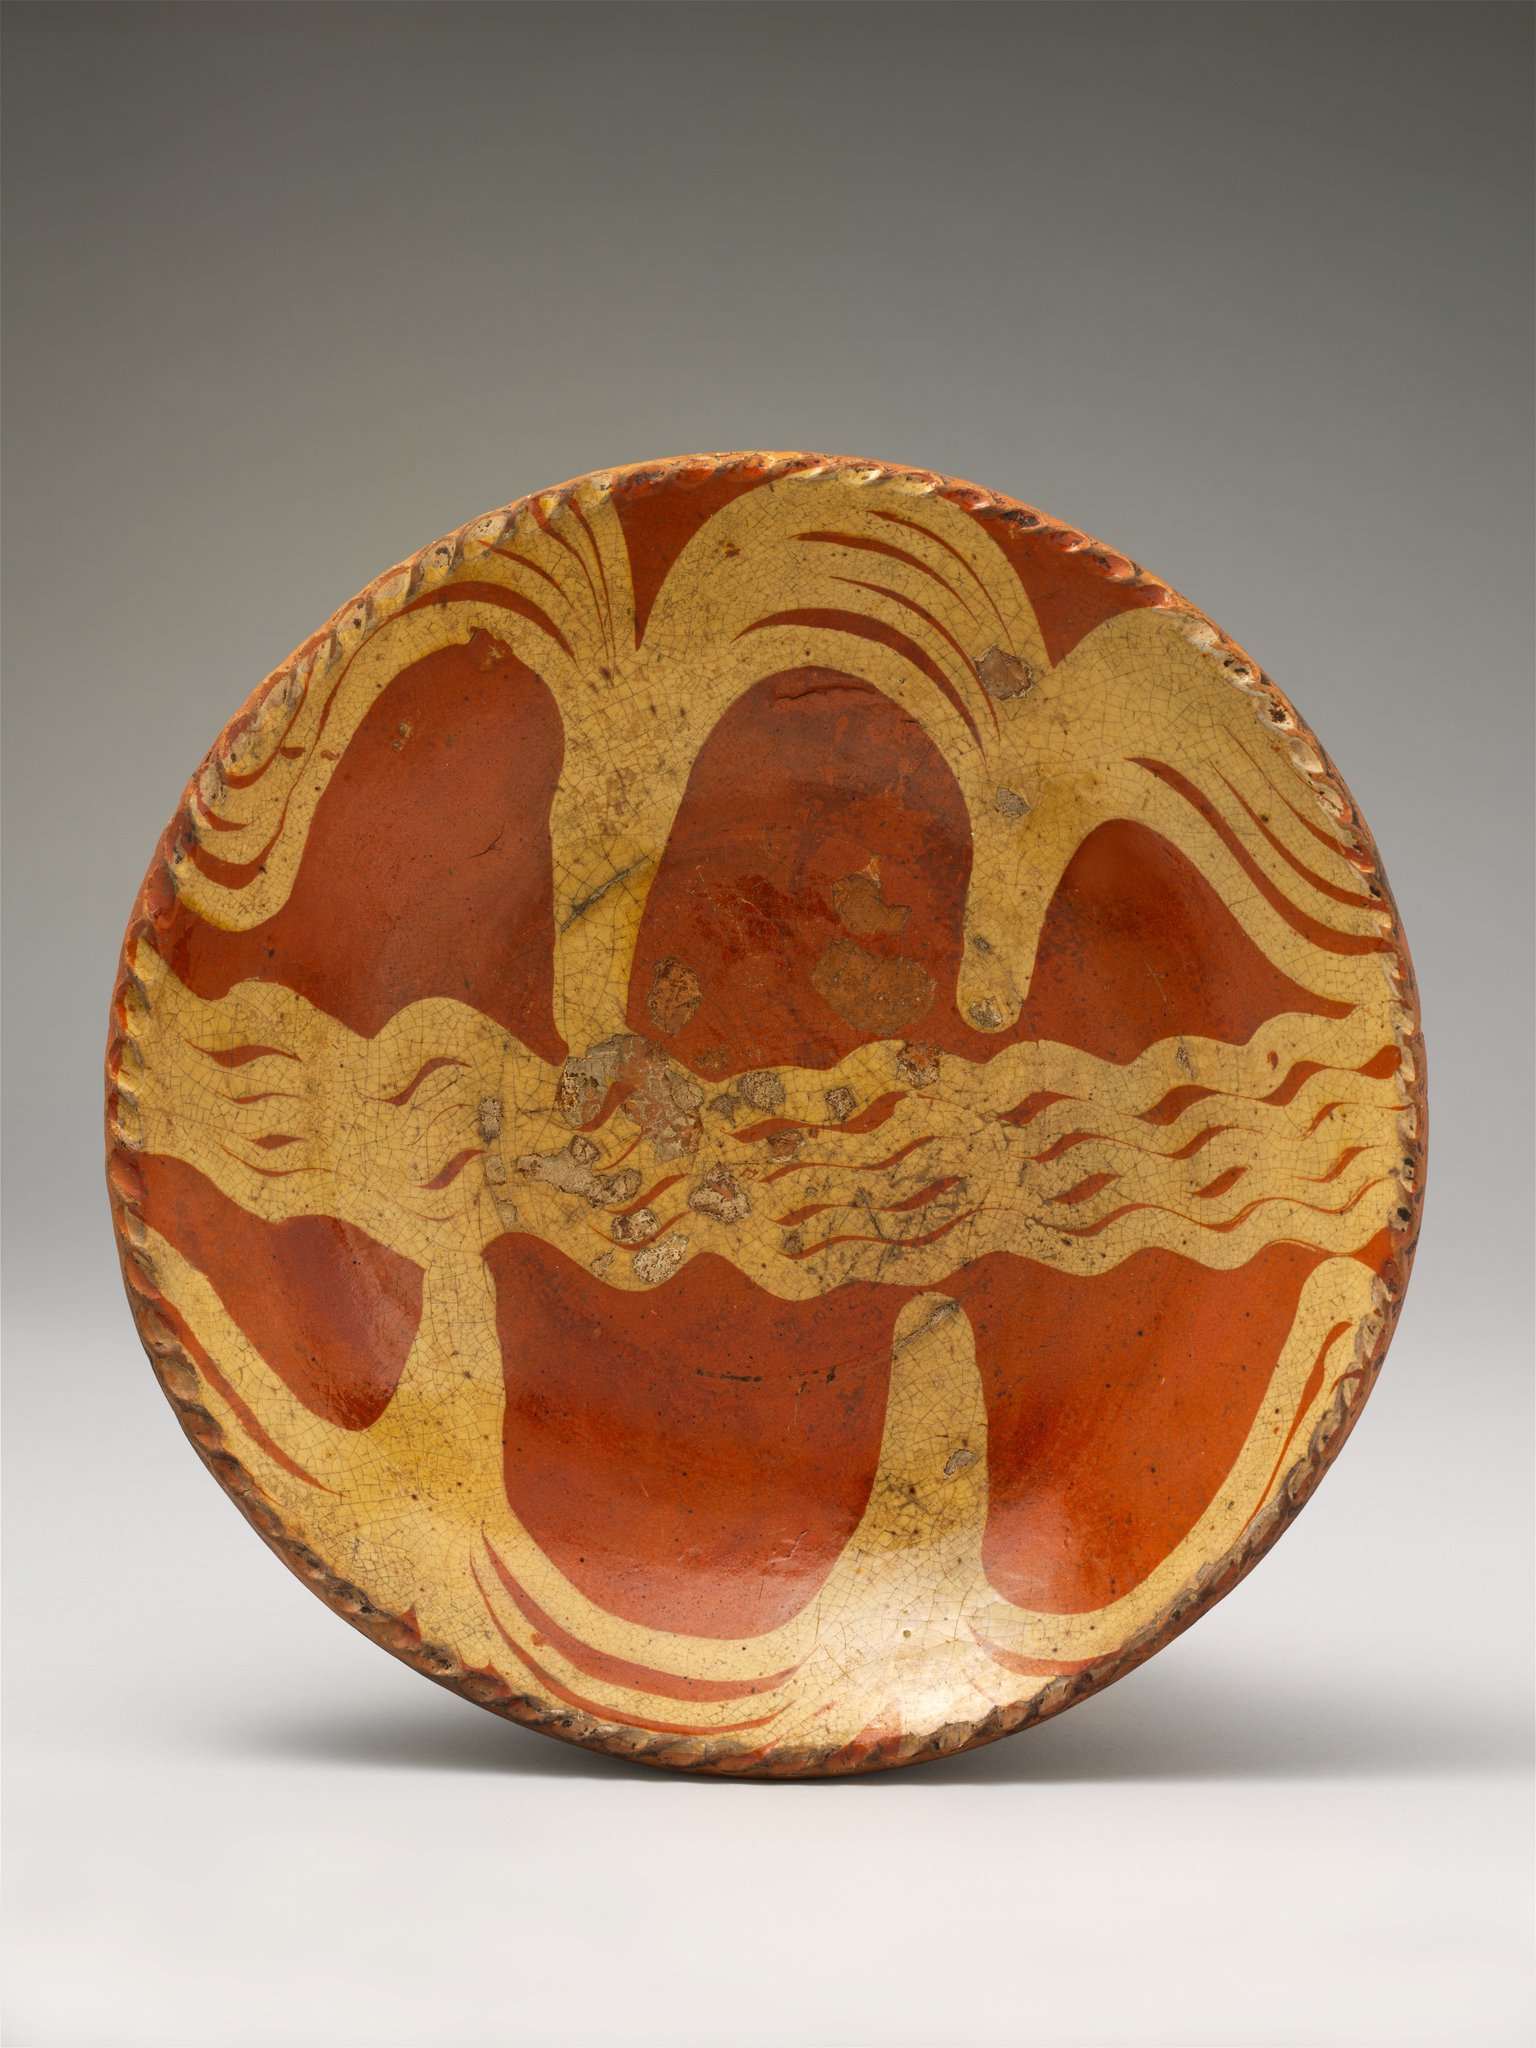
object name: plate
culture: american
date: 1770-1800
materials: earthenware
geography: united states